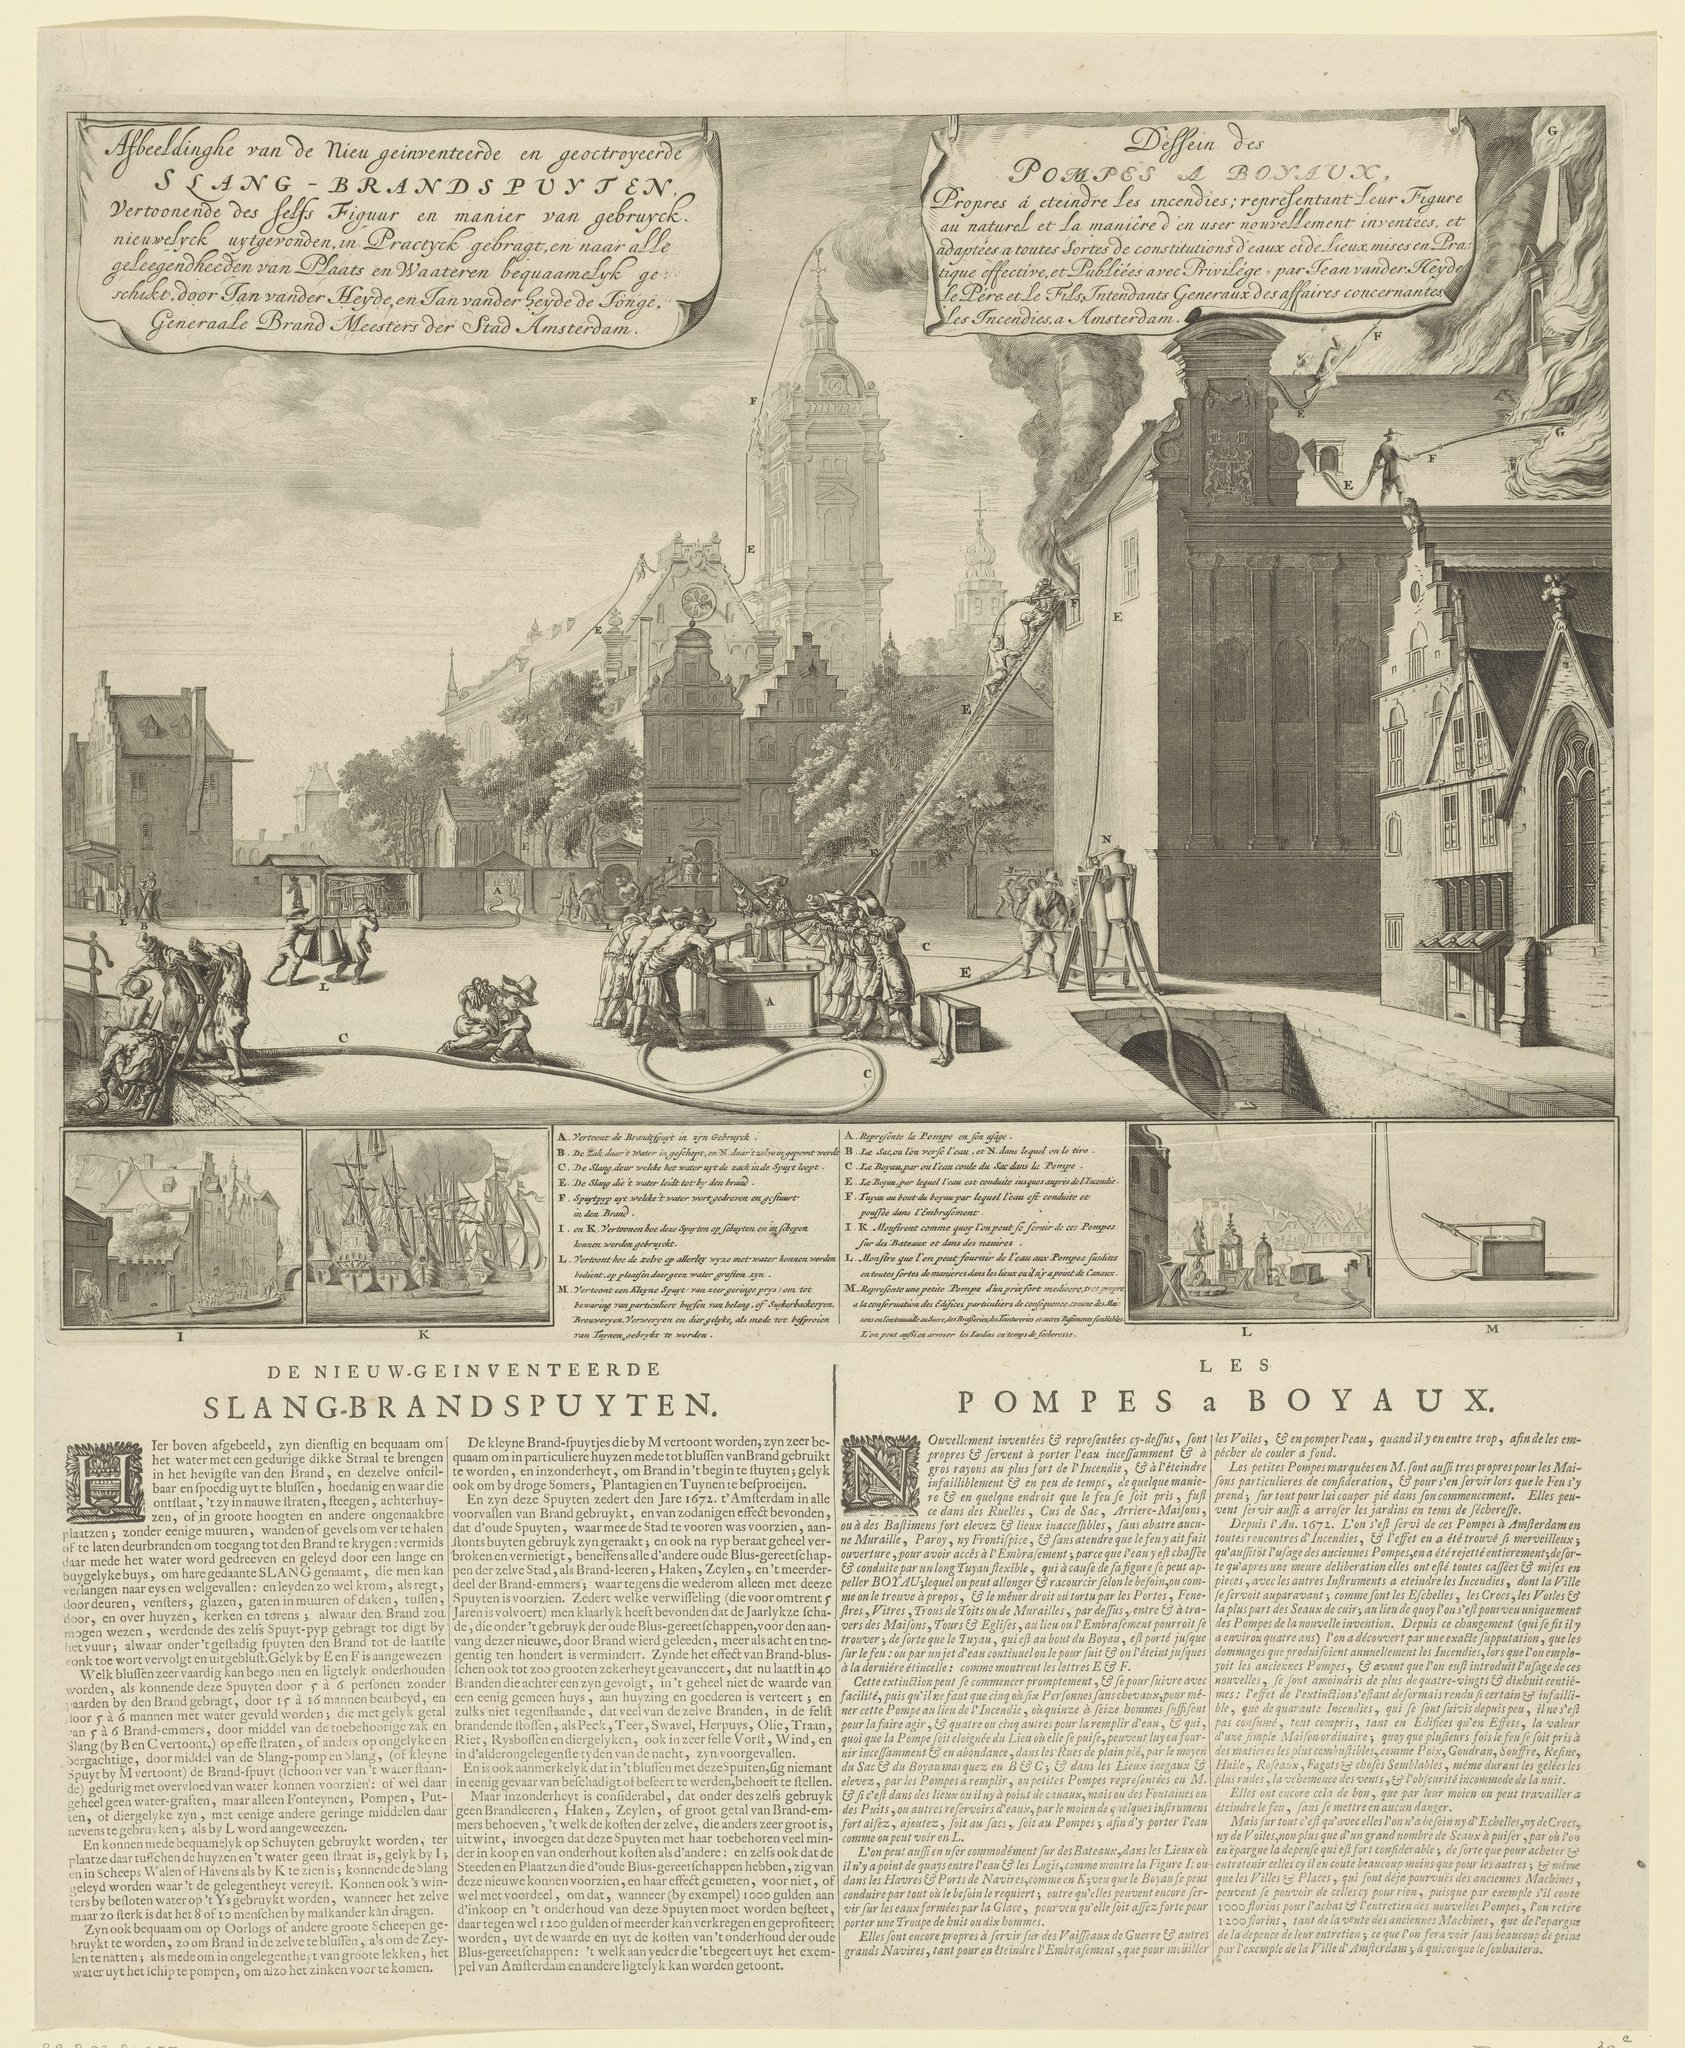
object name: print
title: Toepassing van de nieuwe brandspuitslangen, 1677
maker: Anonymous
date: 1677-1699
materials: paper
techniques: engraving, etching, letterpress printing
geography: northern netherlands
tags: amsterdam, painter, print maker, draughtsman, jan van der heyden, jan van der heyden (de jonge), fire-extinguishing equipment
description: Blad met een grote voorstelling van de toepassing van de nieuwe slangbrandspuiten van Jan van der Heyden en Jan van der Heyden de Jonge bij het blussen van een brand in een gebouw in een imaginaire stad. Bovenaan twee doeken met de titels in het Nederlands en Frans. Onderaan vier kleine voorstellingen van branden in huizen en op een schip en een model van de pomp. Hierbij de legenda A-M in Nederlands en Frans. Op het blad onder de plaat is een tekst gedrukt met een beschrijving in 4 kolommen in het Nederlands en Frans. Behoort tot de bijprenten bij het Brandspuitenboek van Jan van der Heyden.